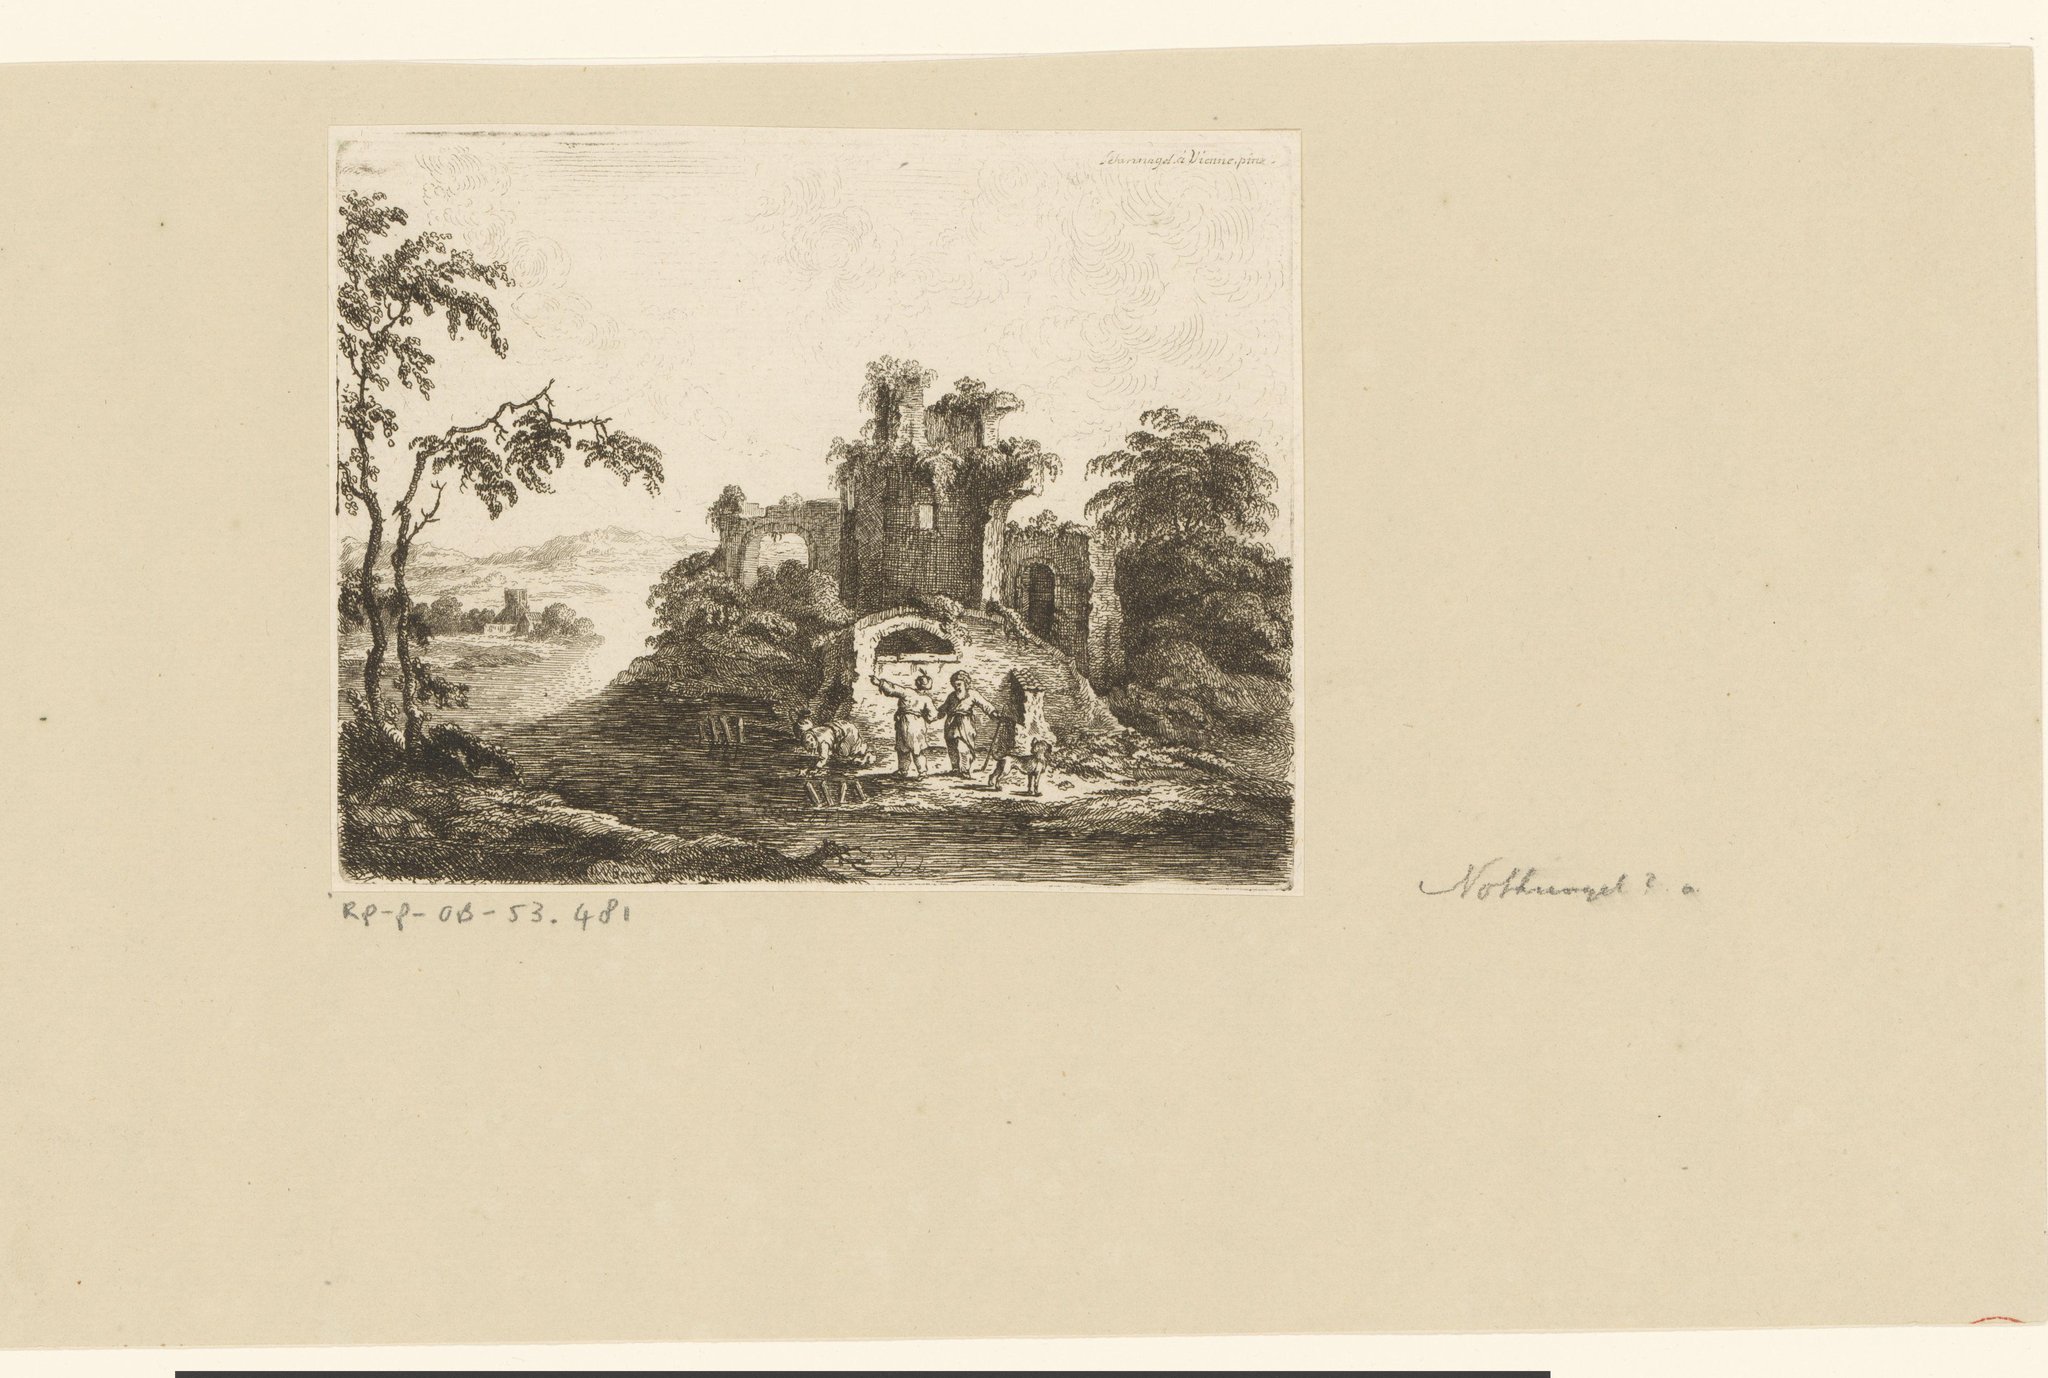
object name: print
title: Landschappen naar schilderijen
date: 1739-1804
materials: paper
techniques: etching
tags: landscape with ruins, dog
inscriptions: collector's mark: Lugt 240